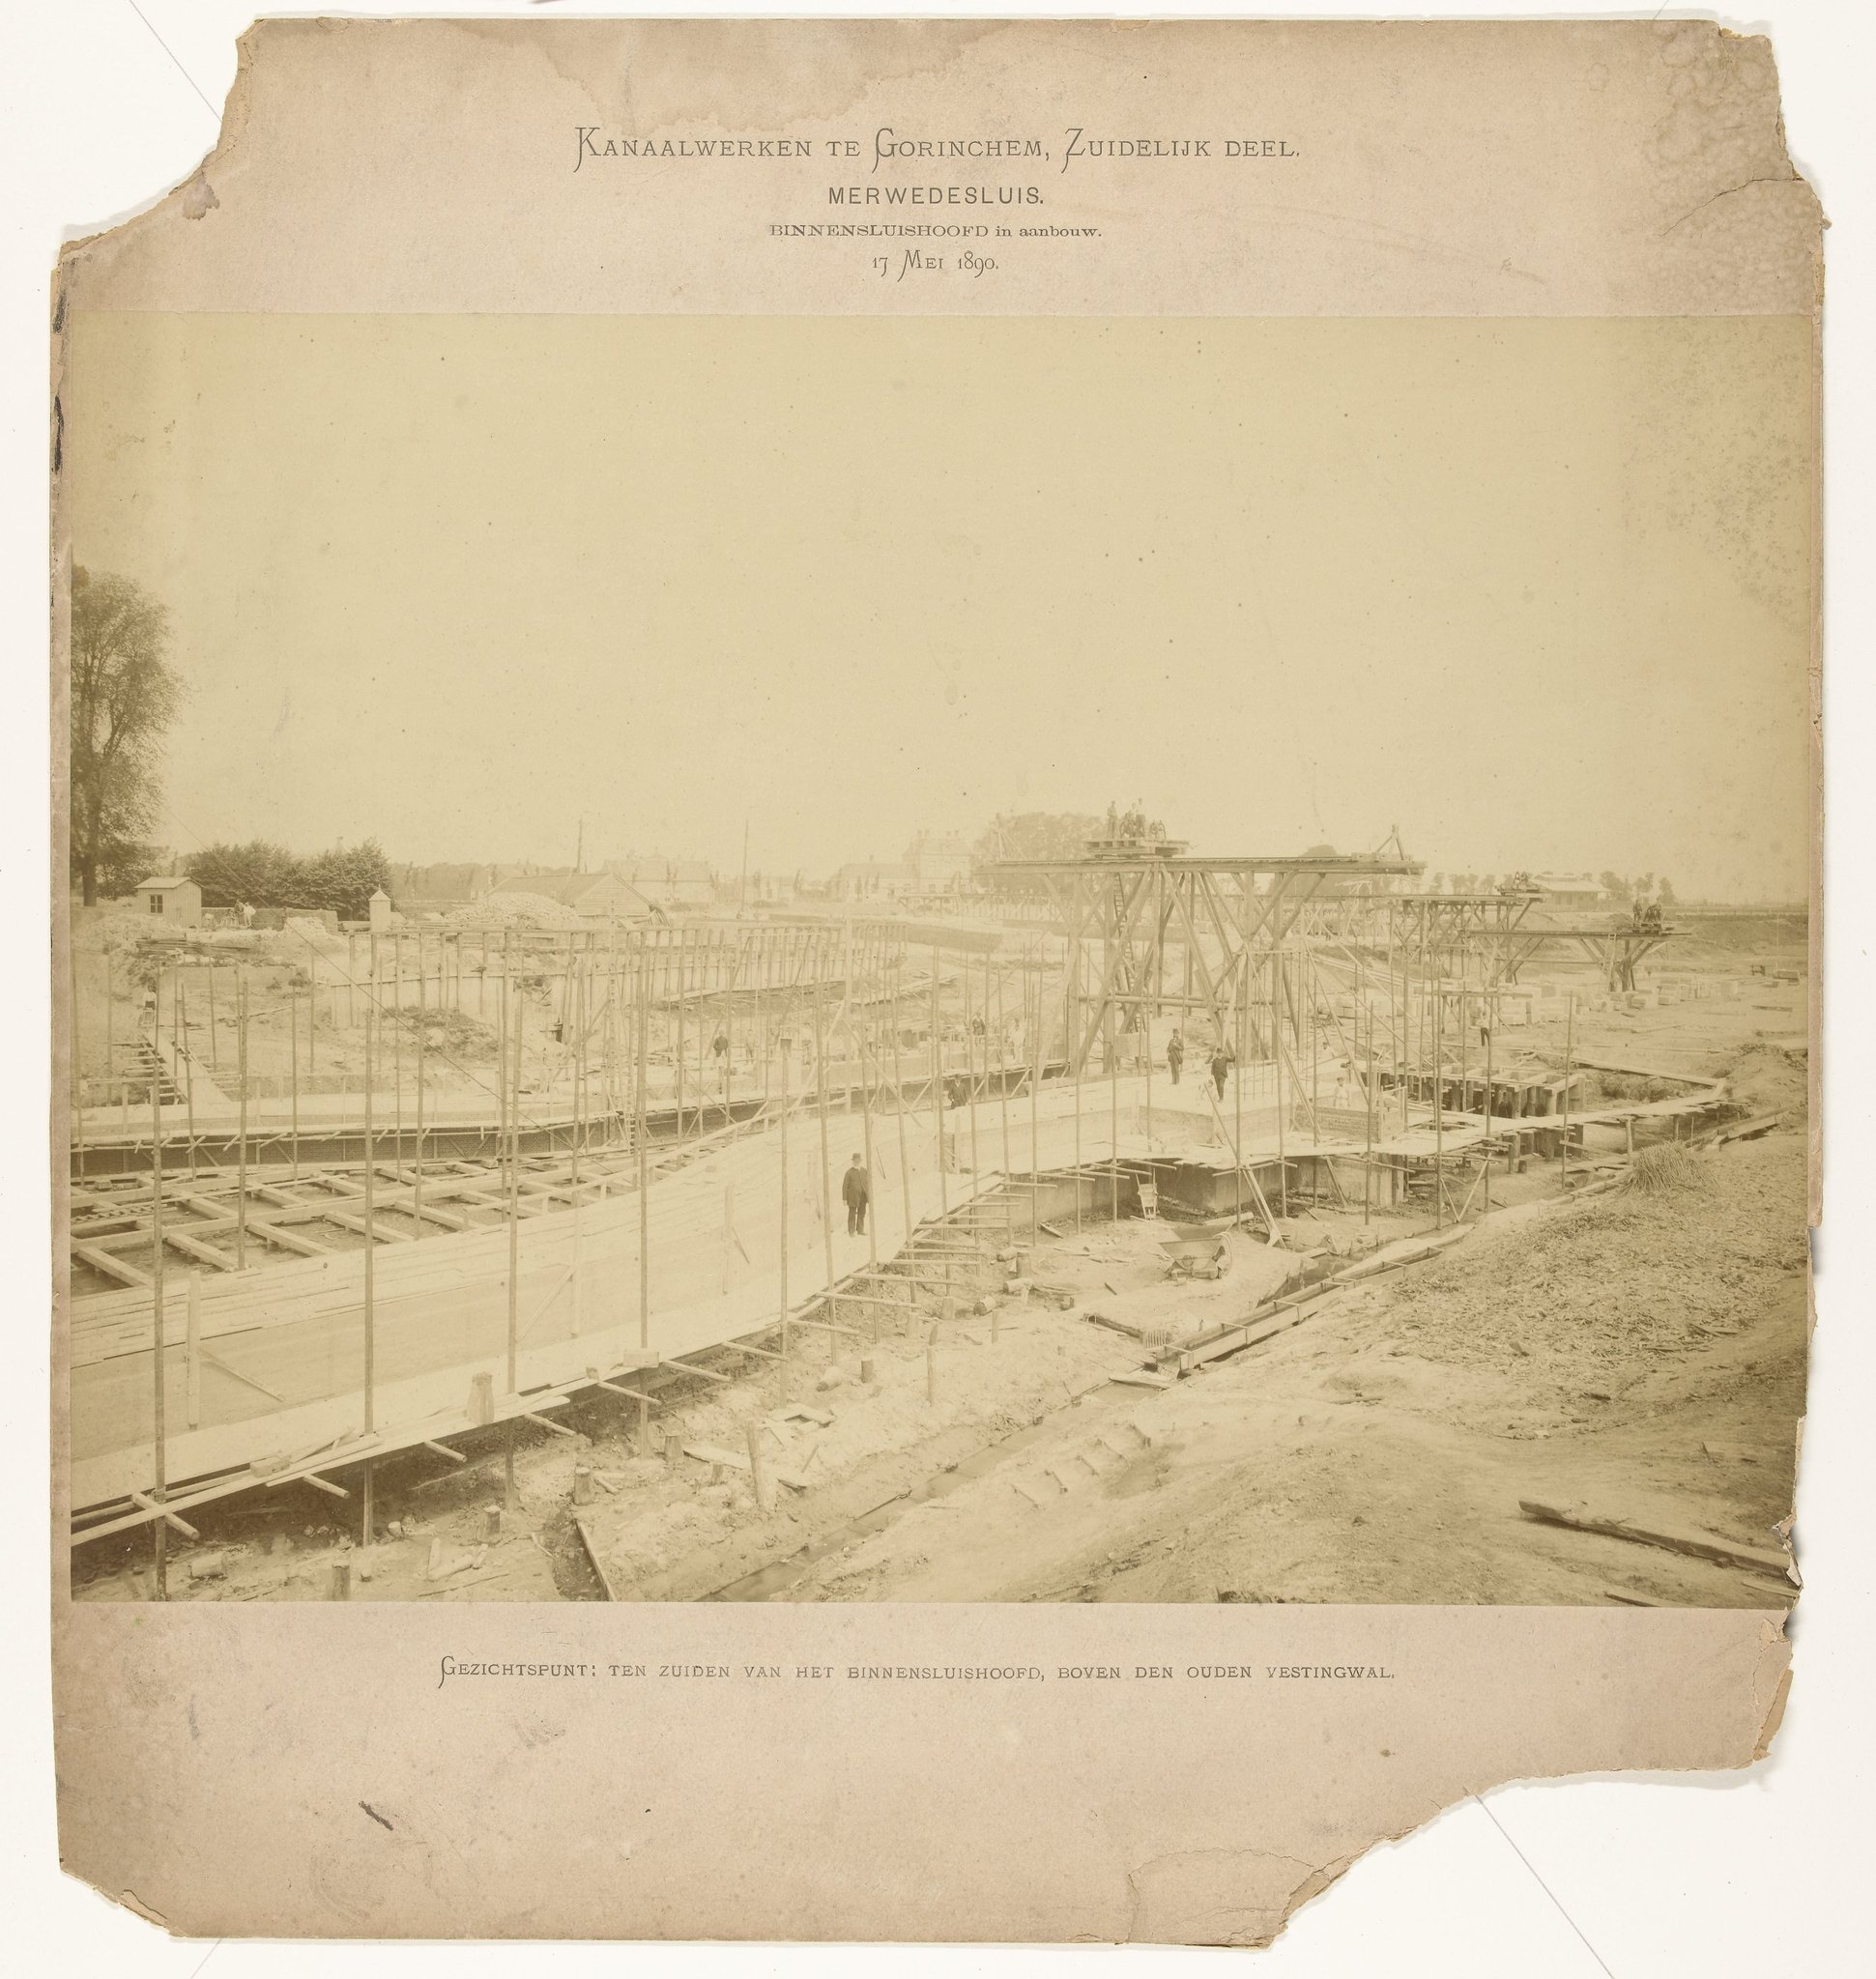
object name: photograph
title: Aanleg van Merwedekanaal te Gorinchem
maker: Anonymous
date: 1890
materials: cardboard, photographic support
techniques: collodion silver print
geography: netherlands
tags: building activities, canal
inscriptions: date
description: Tekst onder de foto beschrijft het exacte gezichtspunt, ten zuiden van het binnensluishoofd, boven de oude vestingwal